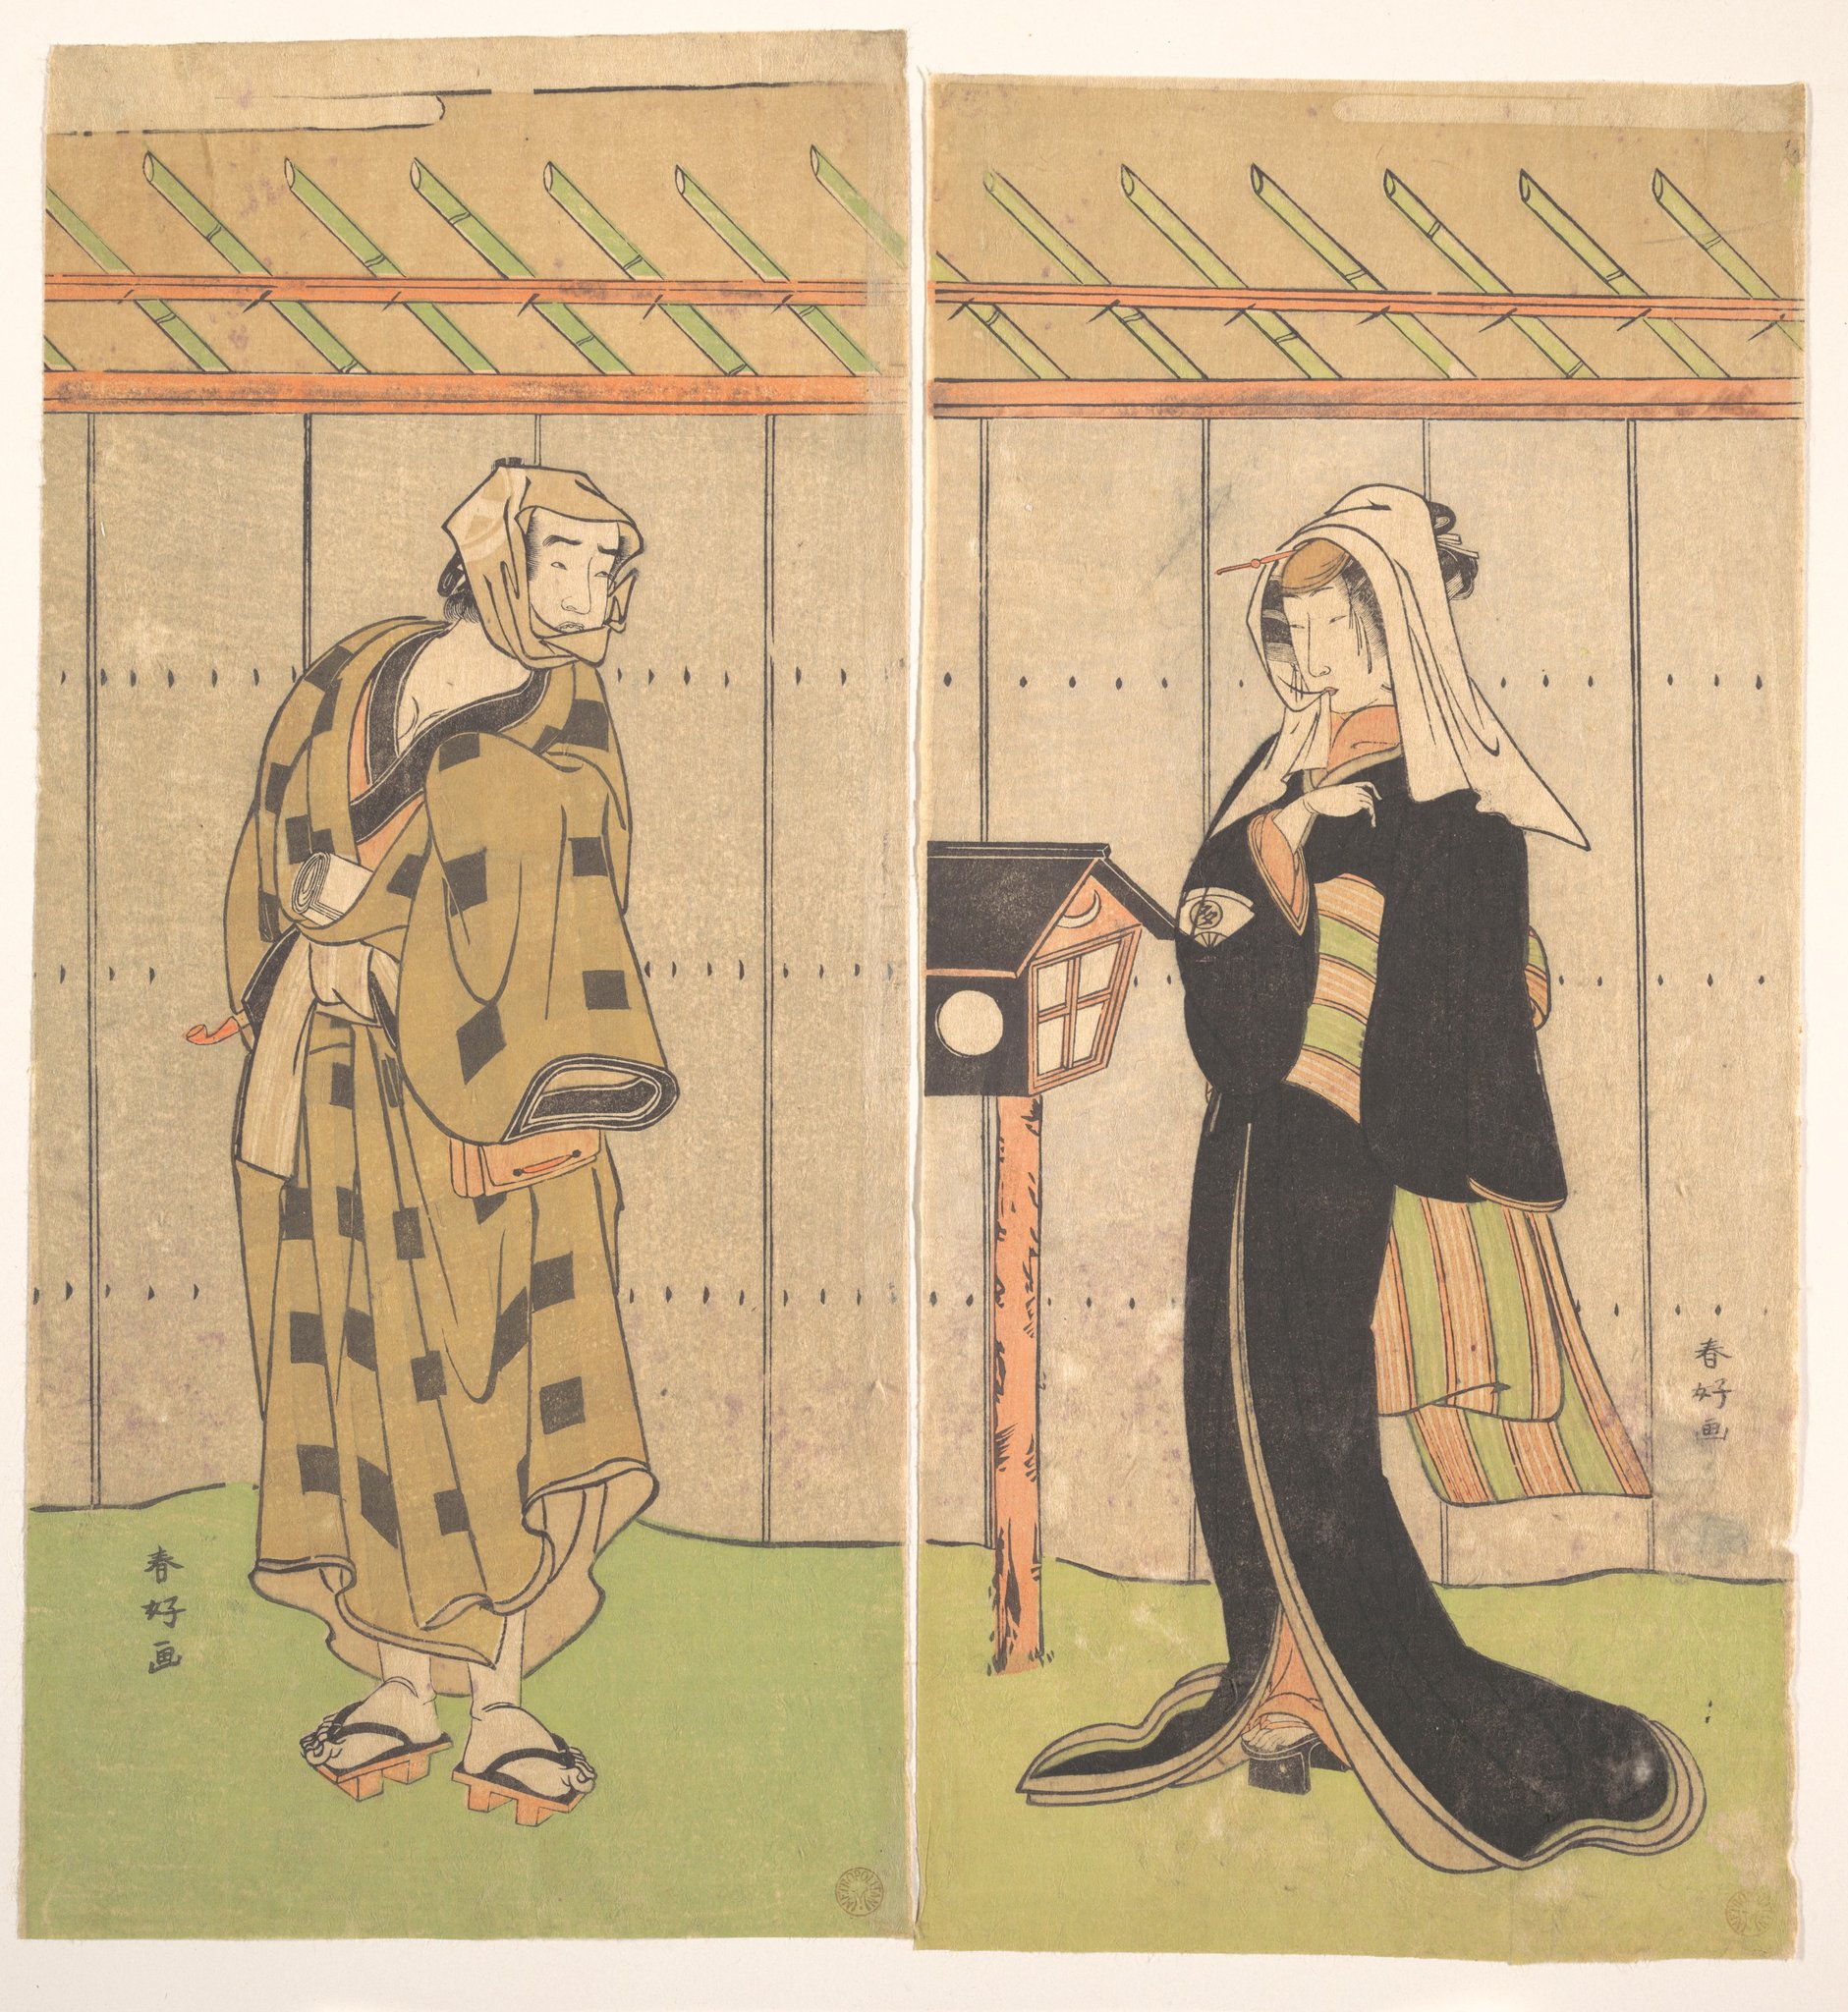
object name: print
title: The Actor Otani Hiroemon as a Man Standing in a Room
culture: japanese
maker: katsukawa shunkō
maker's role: artist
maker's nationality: japanese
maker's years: 1743-1812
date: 1789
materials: ink, paper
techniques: woodblock print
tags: men,actors